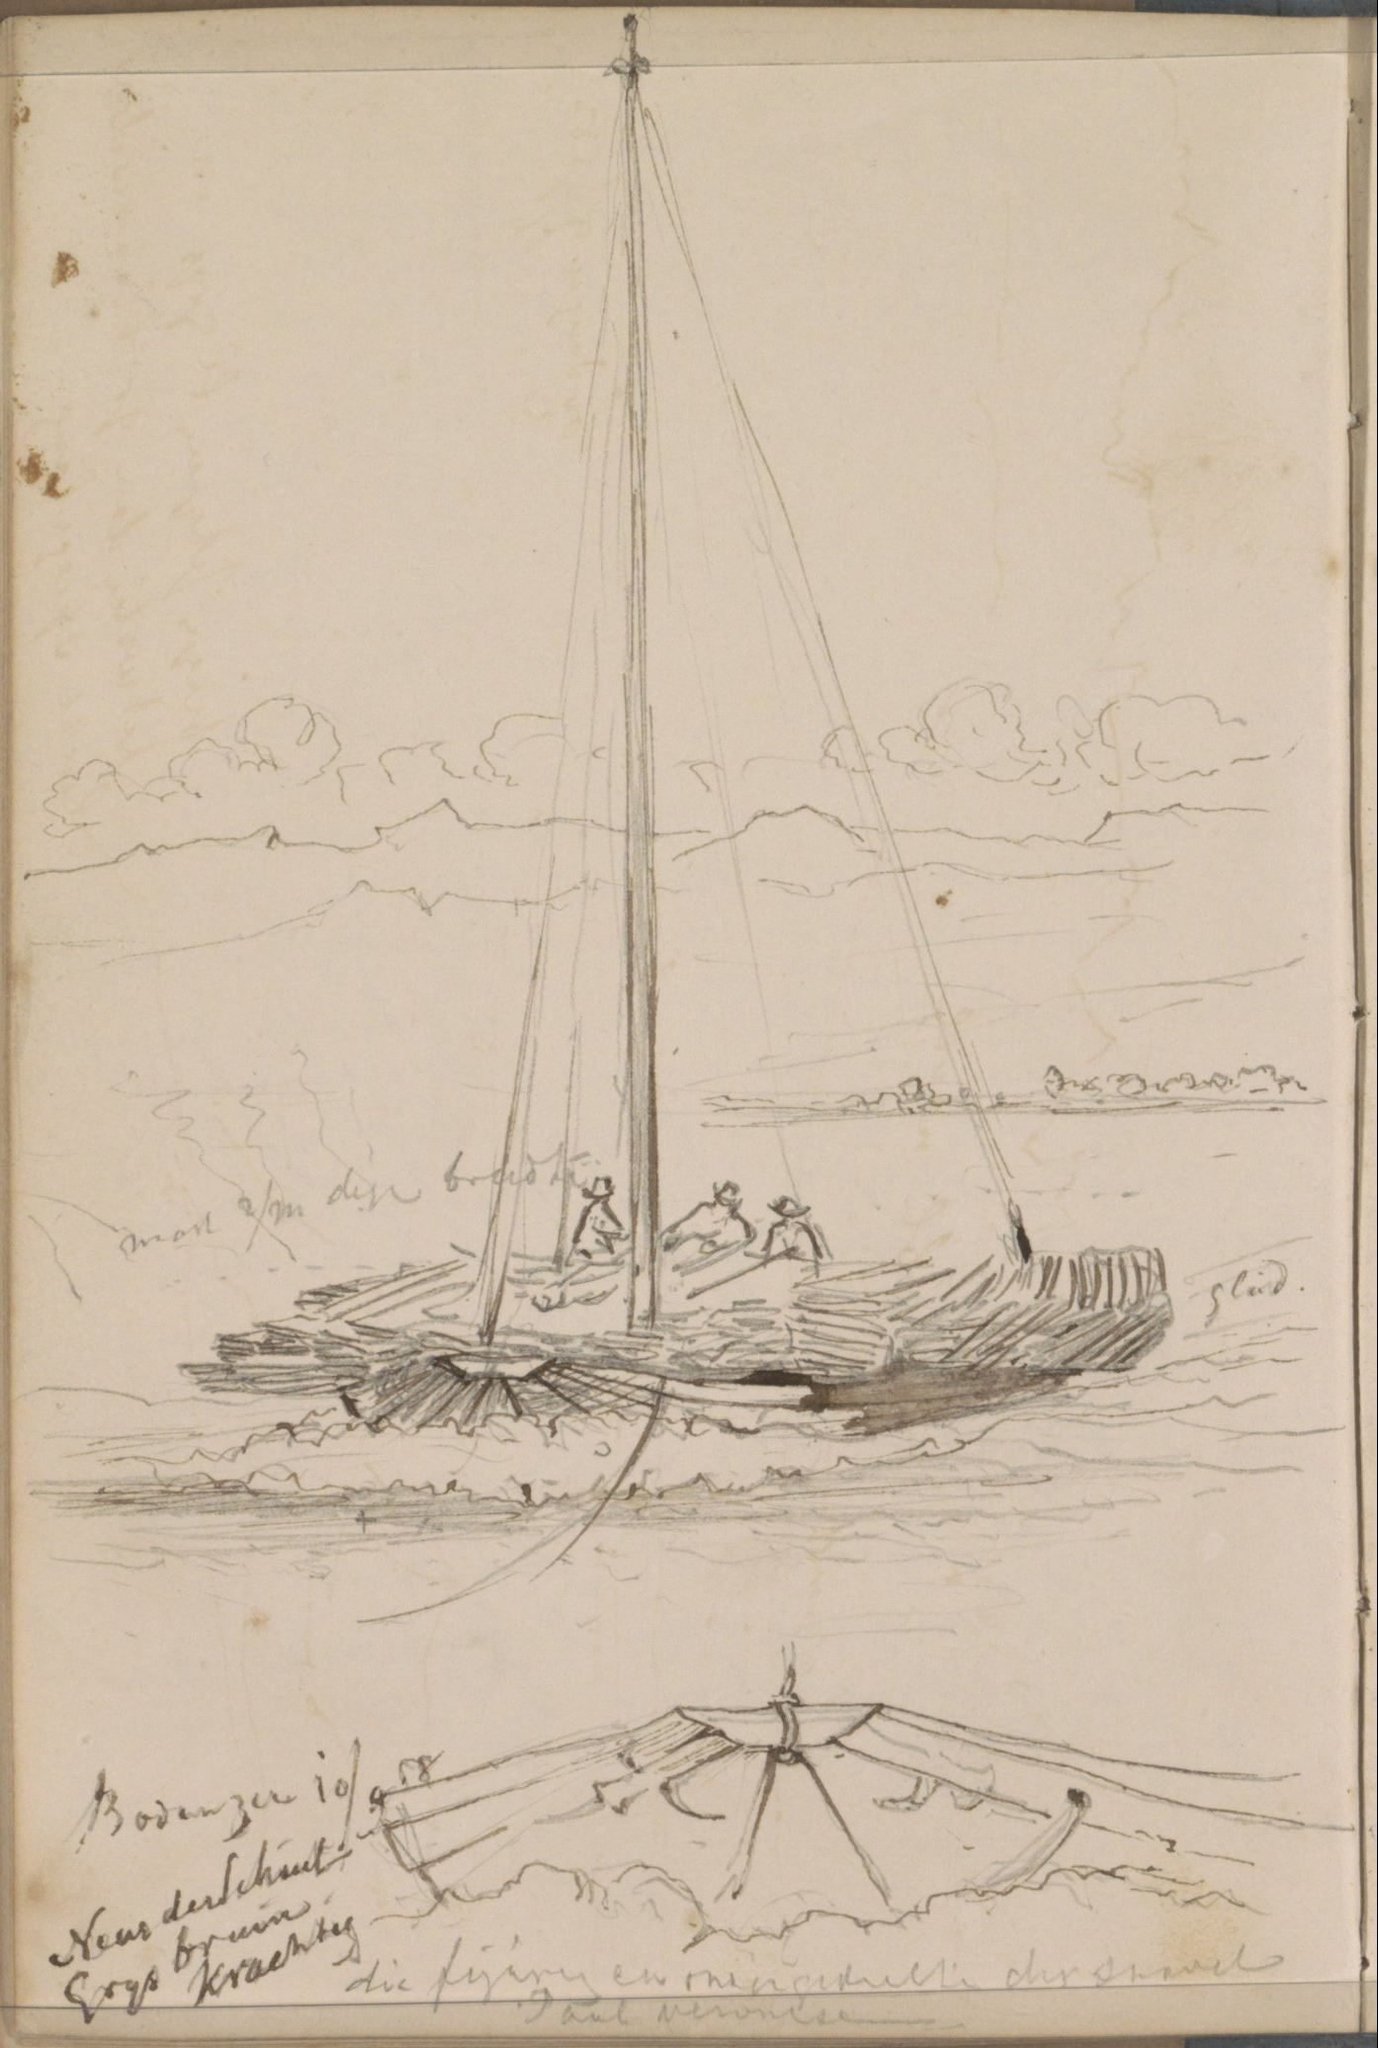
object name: sketchbook leaf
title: Figuren in een schuit op het Bodenmeer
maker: johannes tavenraat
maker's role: draughtsman, painter, print maker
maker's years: 1809-1881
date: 1809-1858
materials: ink, paper, pencil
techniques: pen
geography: lake constance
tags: sailing-ship, sailing-boat, lake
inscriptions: date and inscription: ‘Bodenzee 10/9 58/ Neus der schuit/ grijs bruin/ krachtig [...]’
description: Blad 28 verso uit een schetsboek met 47 bladen.